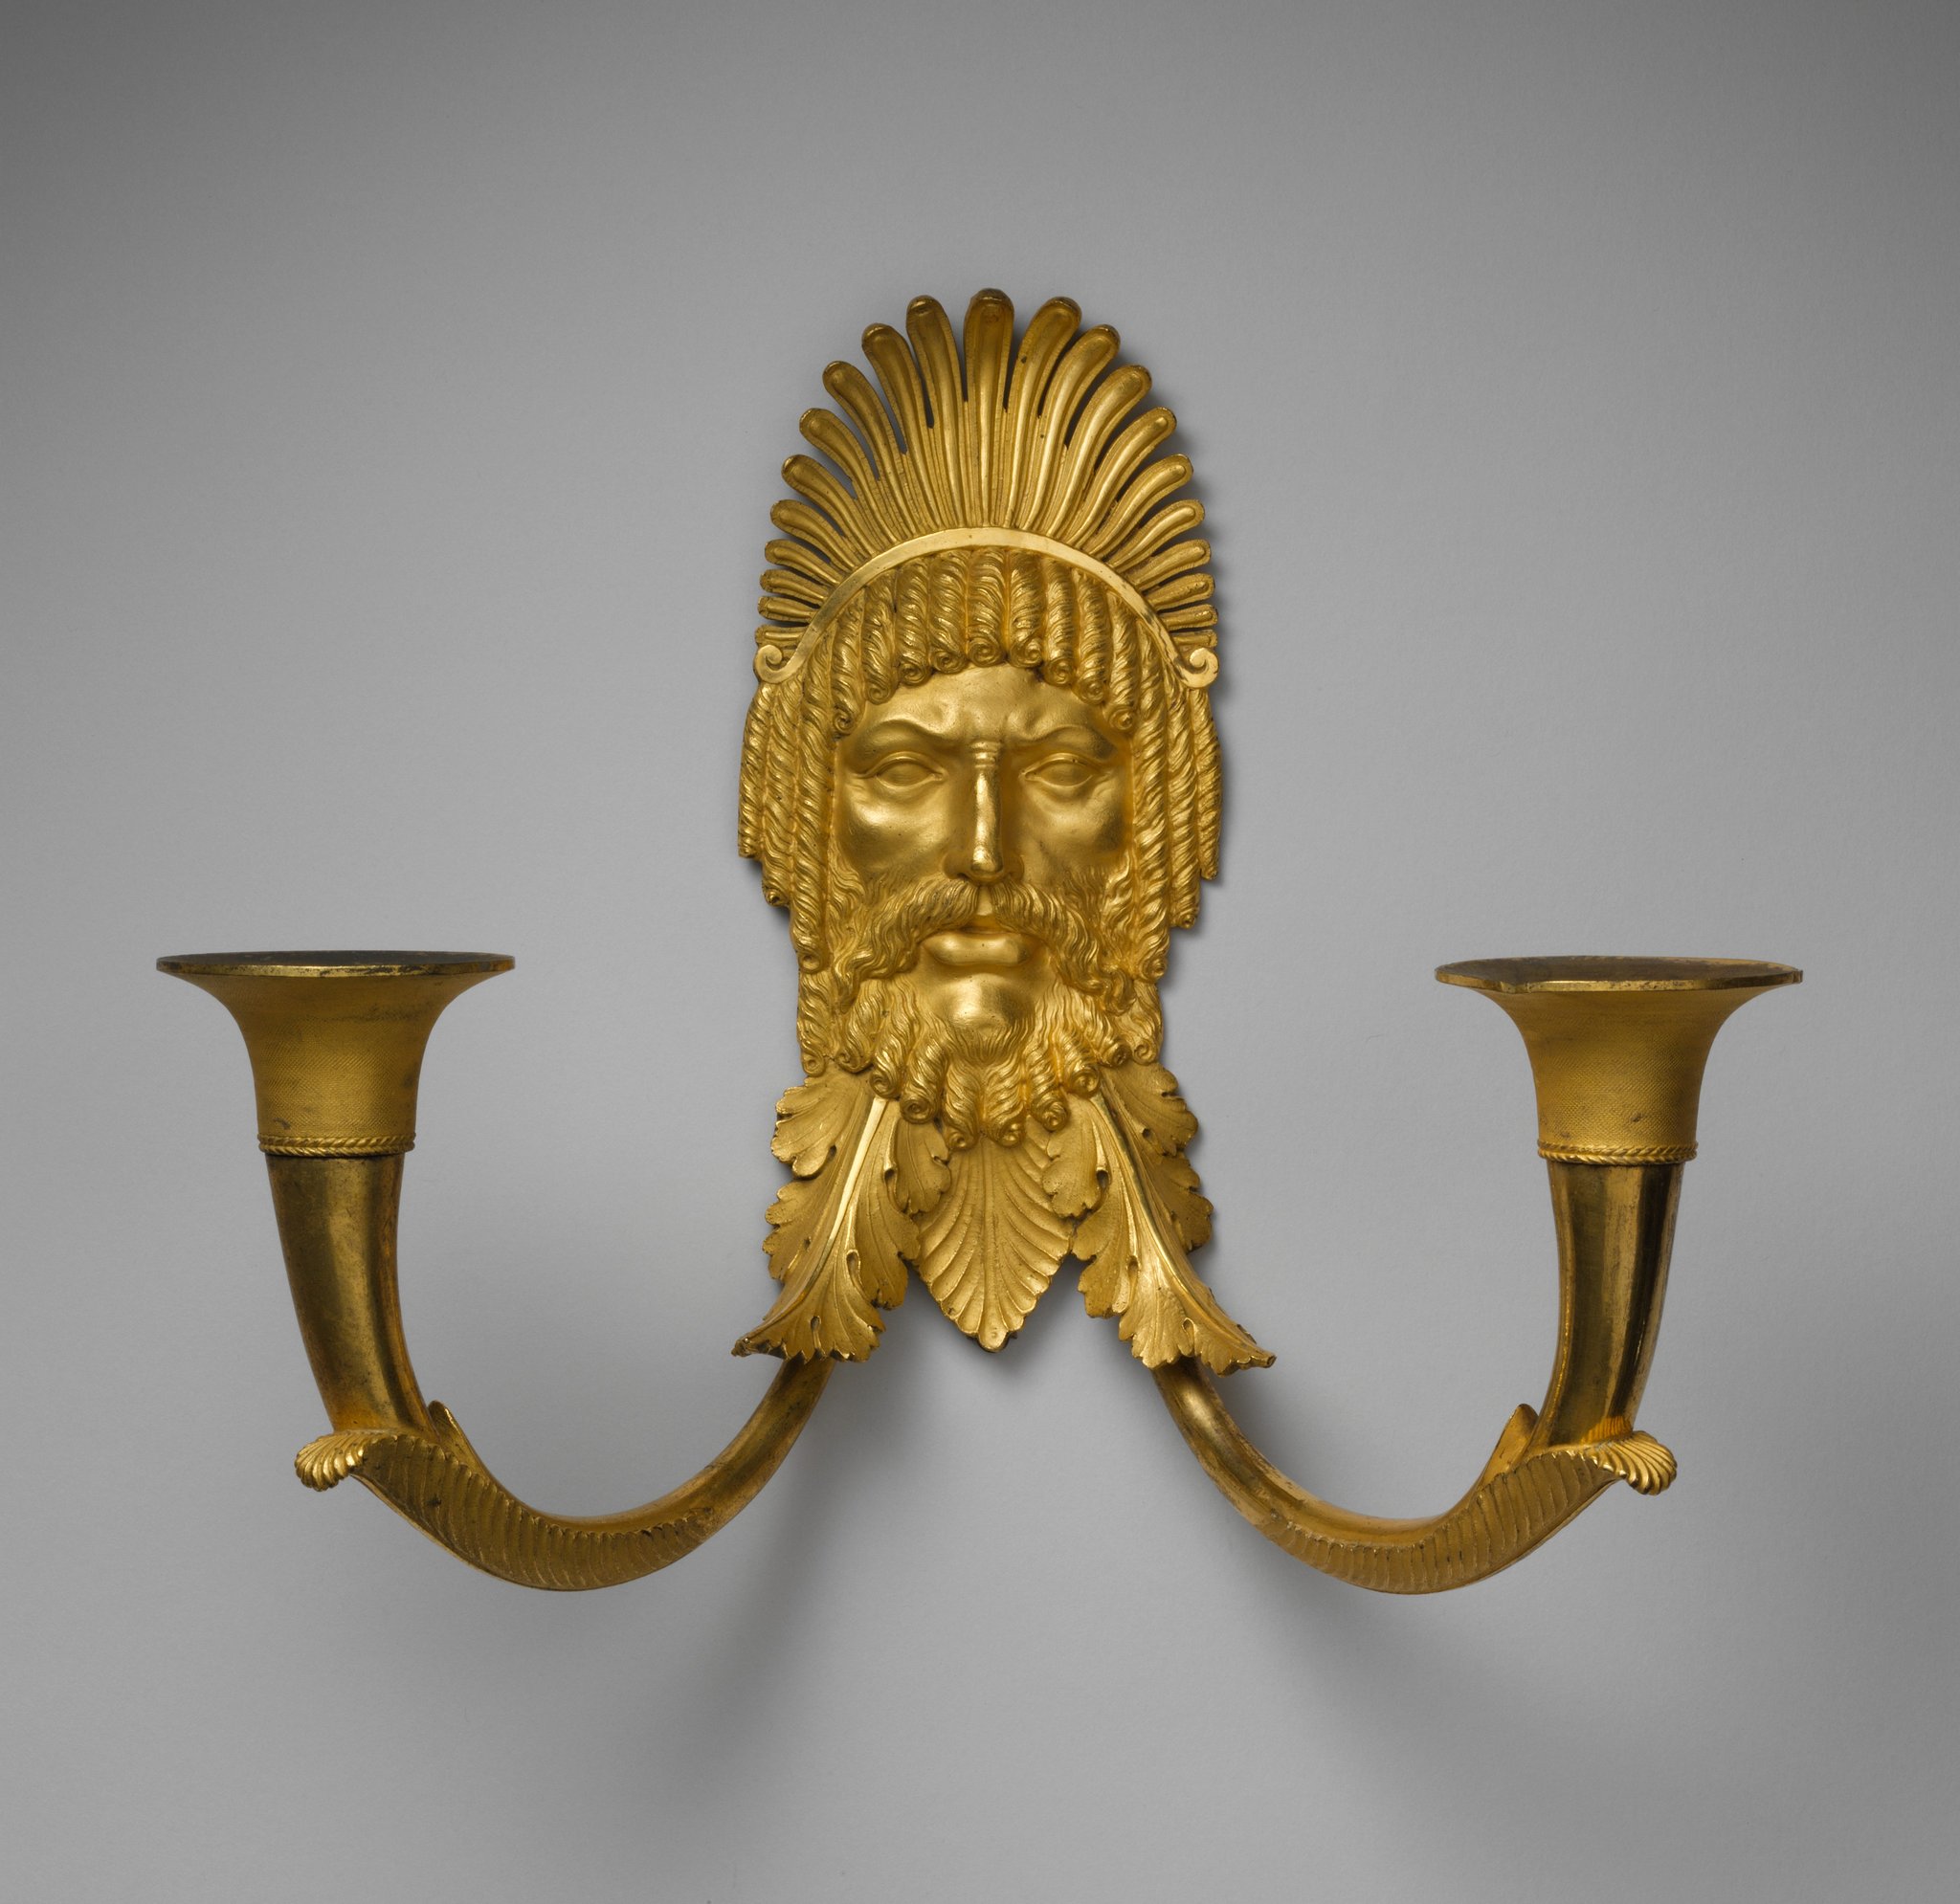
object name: wall bracket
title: Two-light wall bracket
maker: antoine-andré ravrio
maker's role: maker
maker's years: 1759-1814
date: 1804-1814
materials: gilt bronze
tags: faces,men